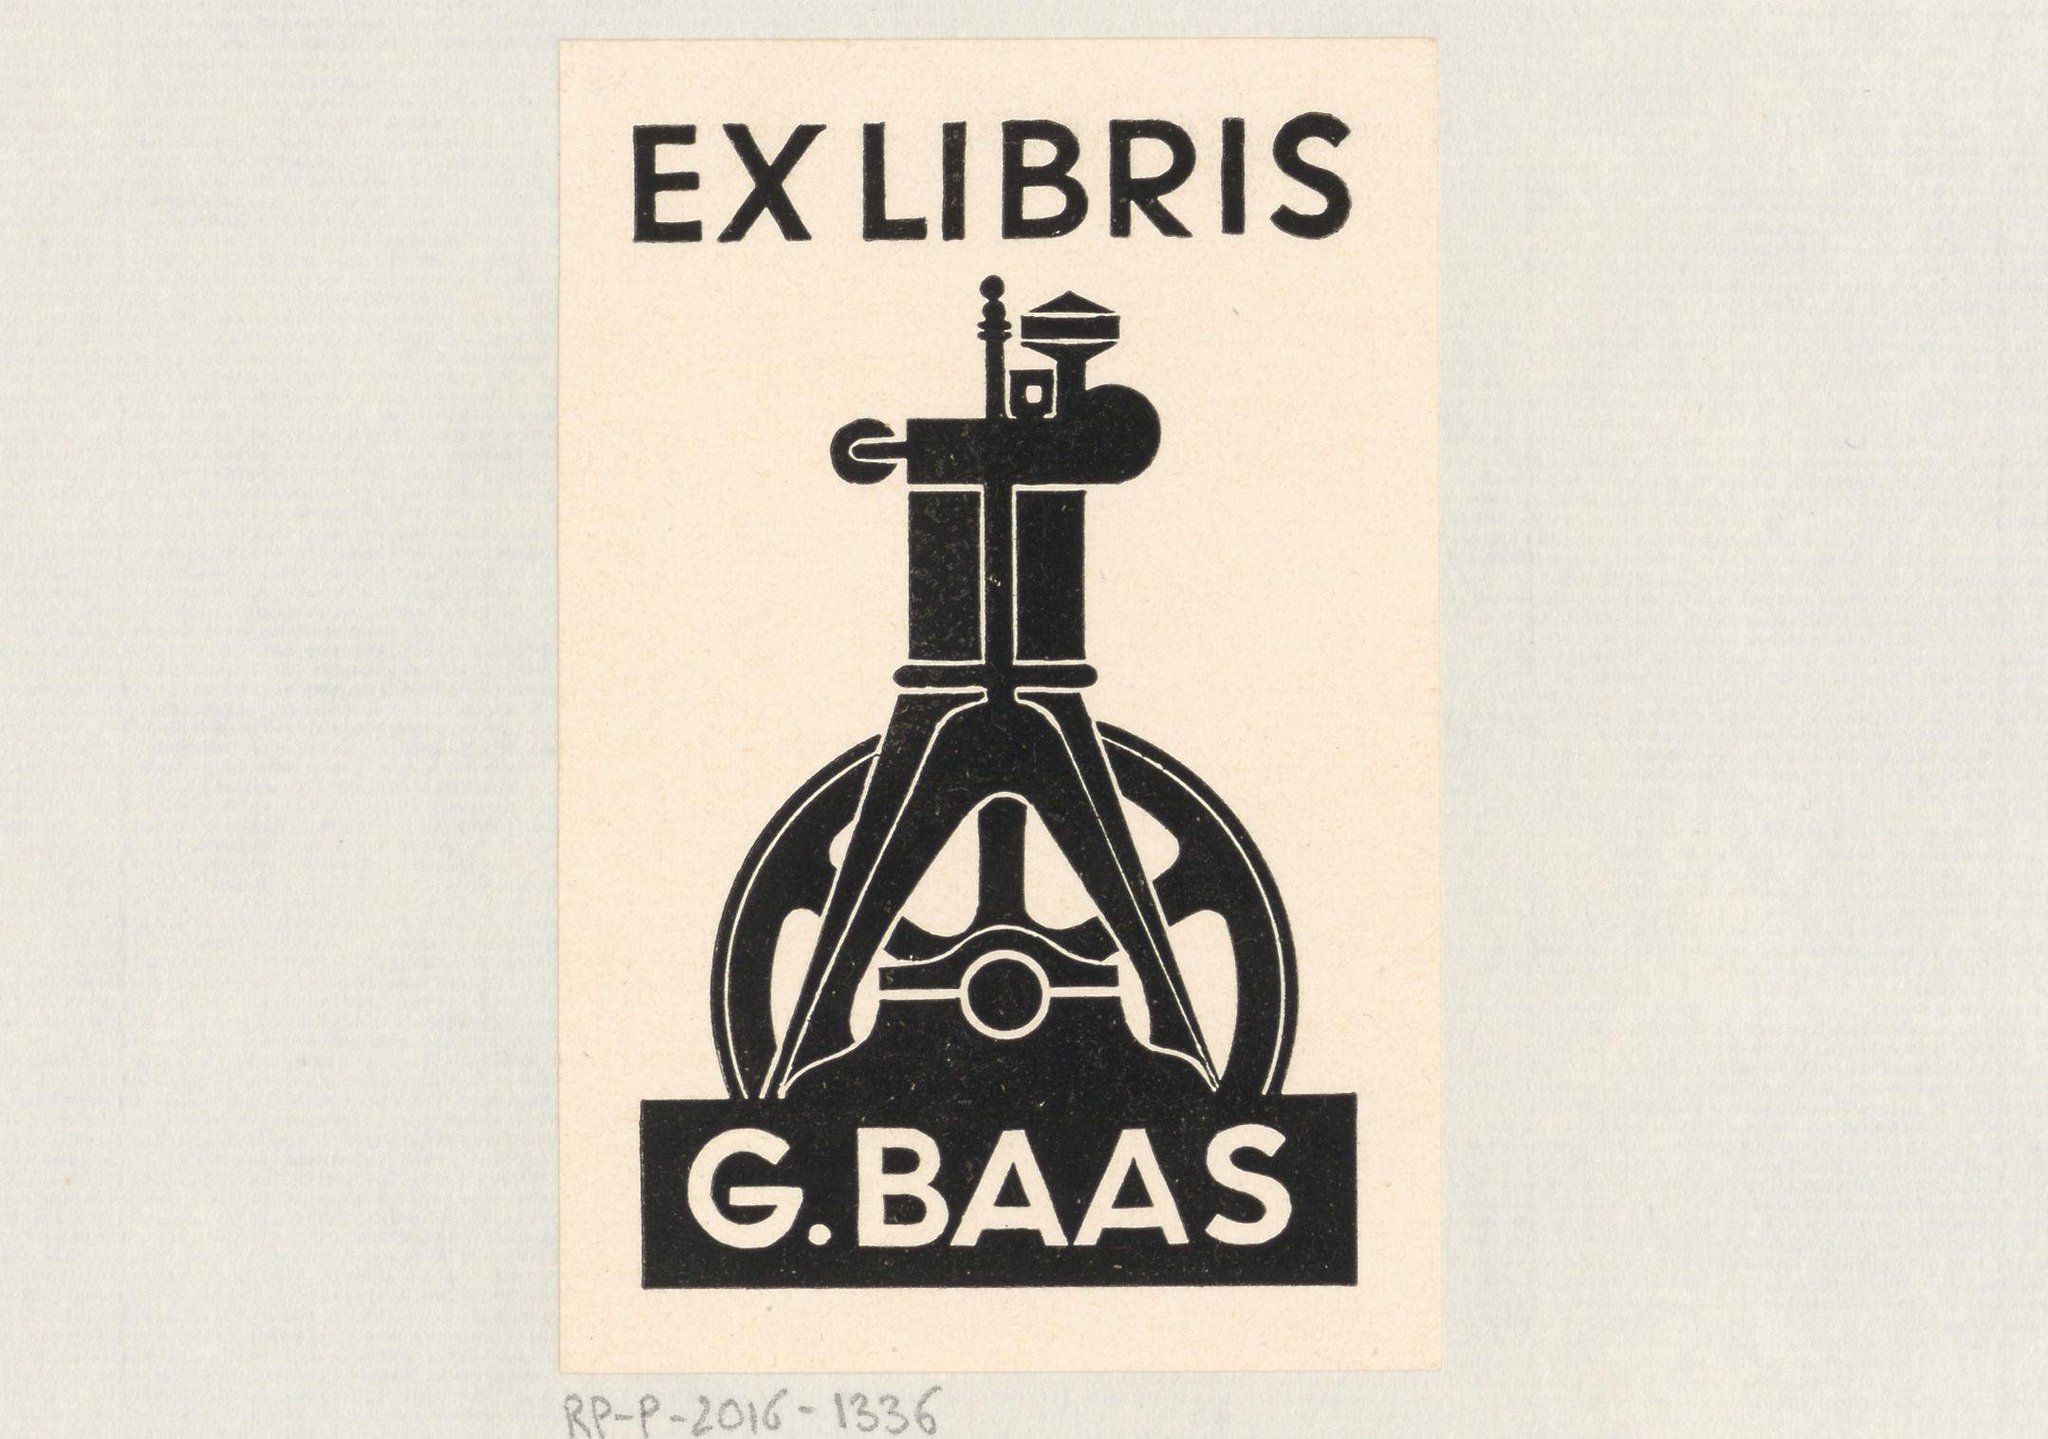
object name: bookplate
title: Ex libris van G. Baas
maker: g. baas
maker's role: print maker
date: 1941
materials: paper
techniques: printing block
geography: netherlands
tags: print maker, g. baas, machines, engines ~ crafts and industries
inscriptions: inscription: ‘Eigen Ontwerp / cl '41’